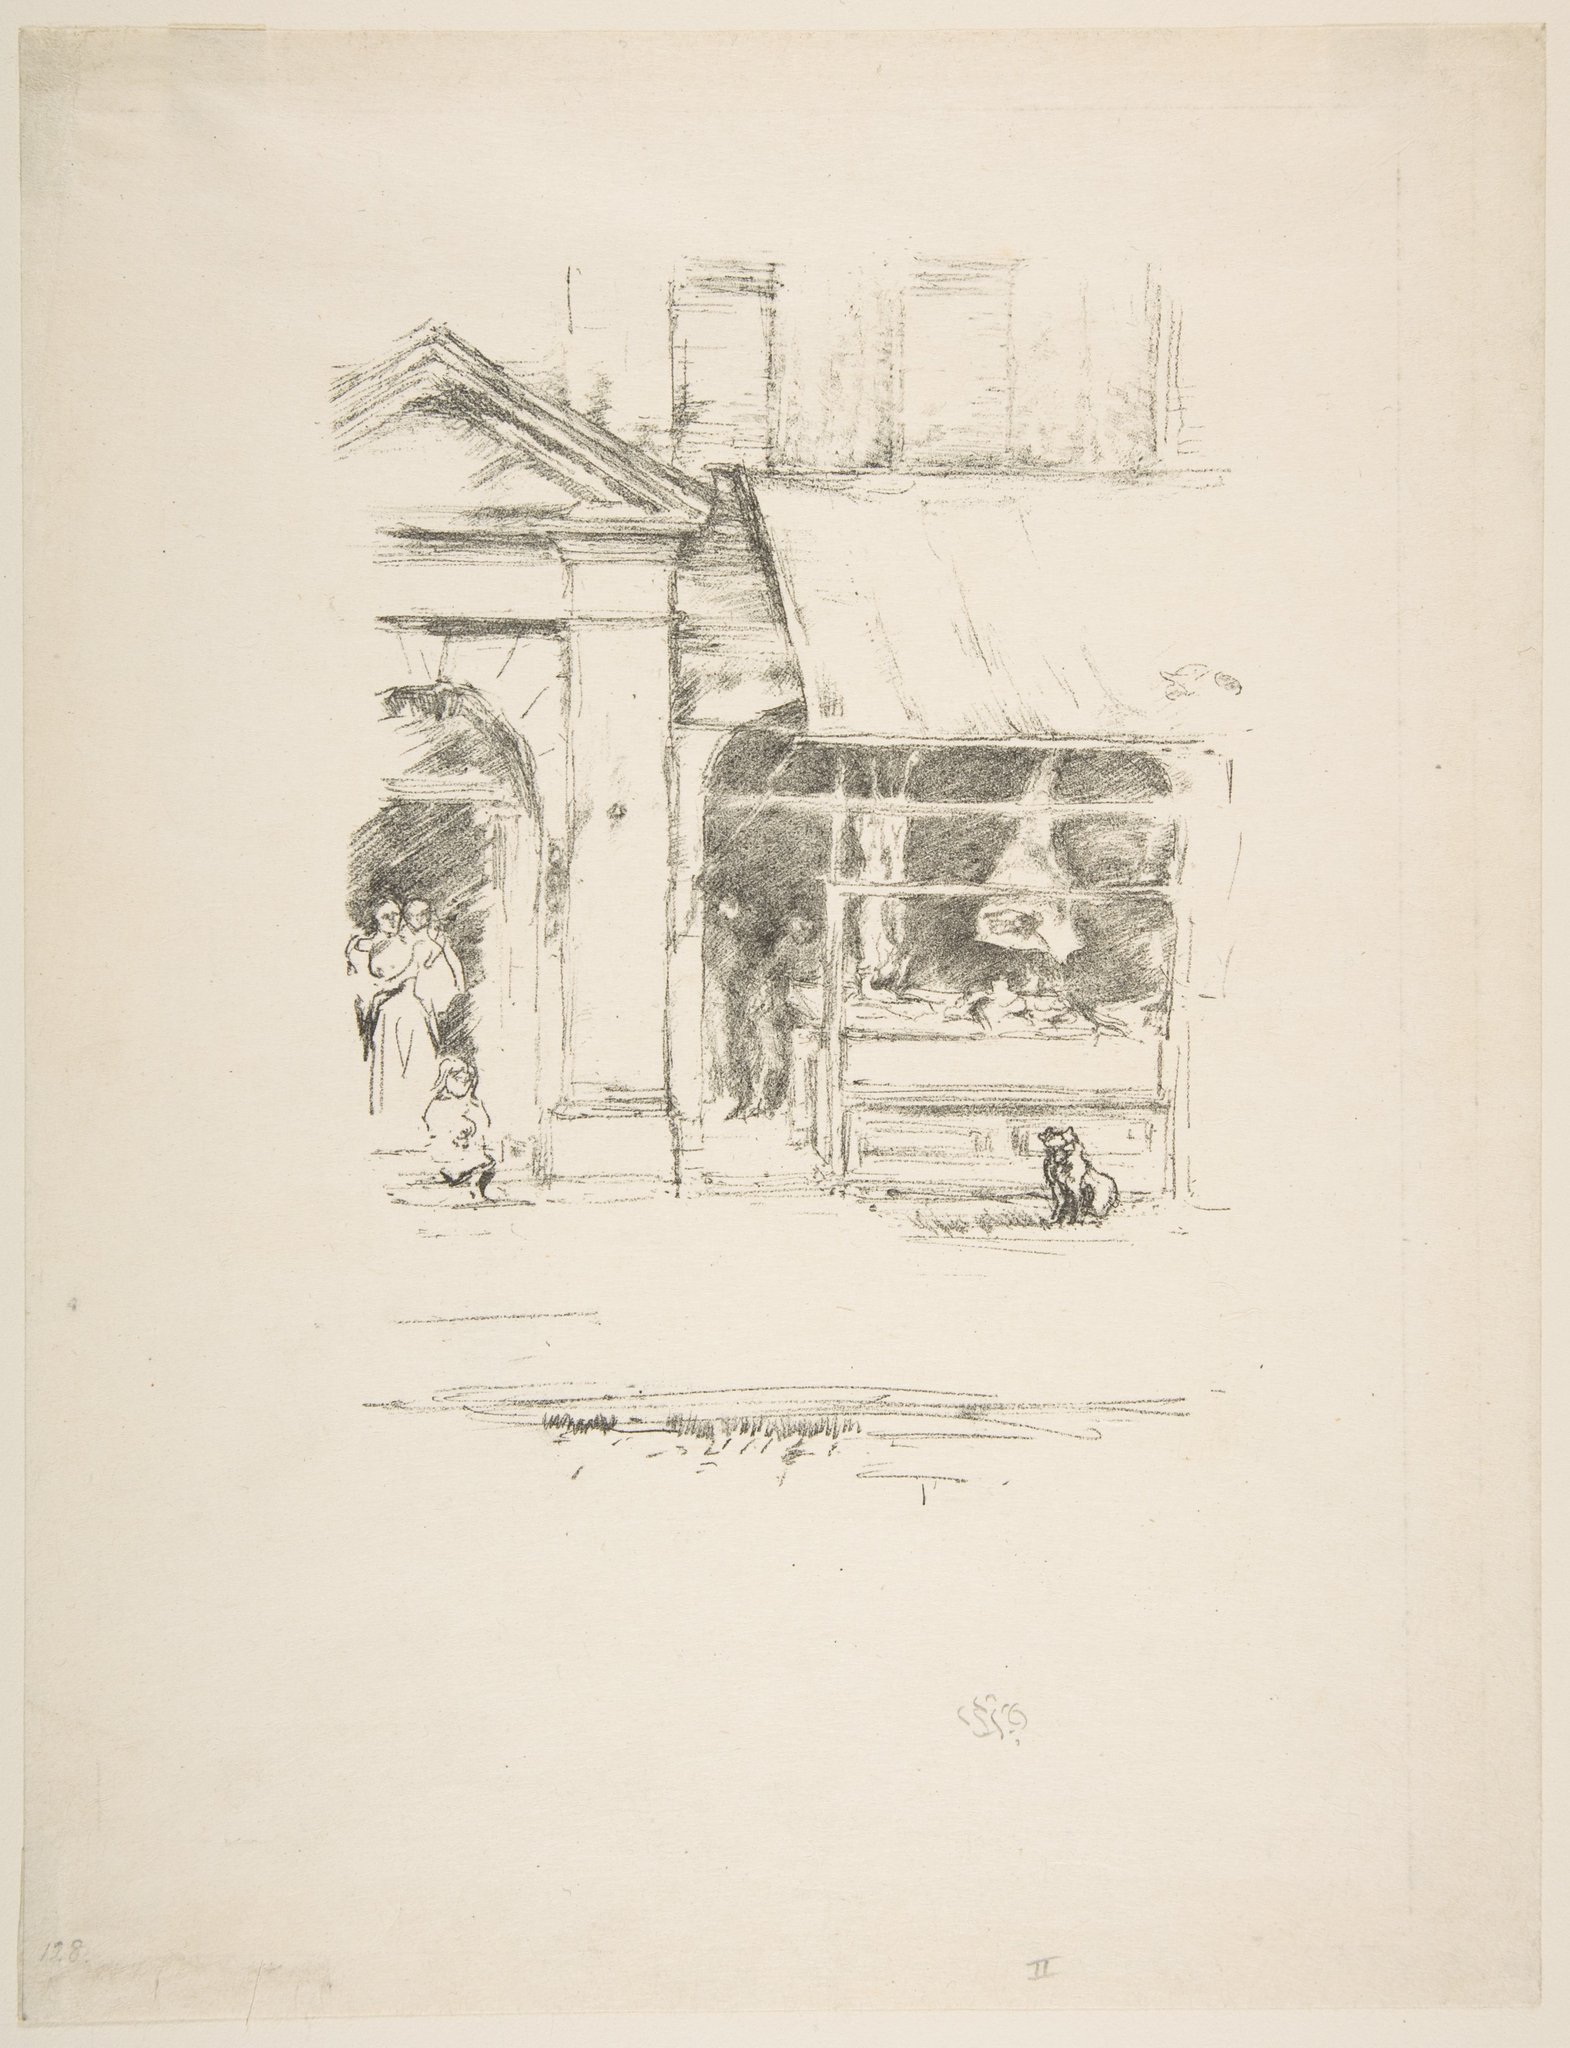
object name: print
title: The Butcher's Dog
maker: james mcneill whistler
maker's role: artist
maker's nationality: american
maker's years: 1834-1903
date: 1896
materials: ink, paper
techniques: printing, lithography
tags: buildings,dogs,butchers